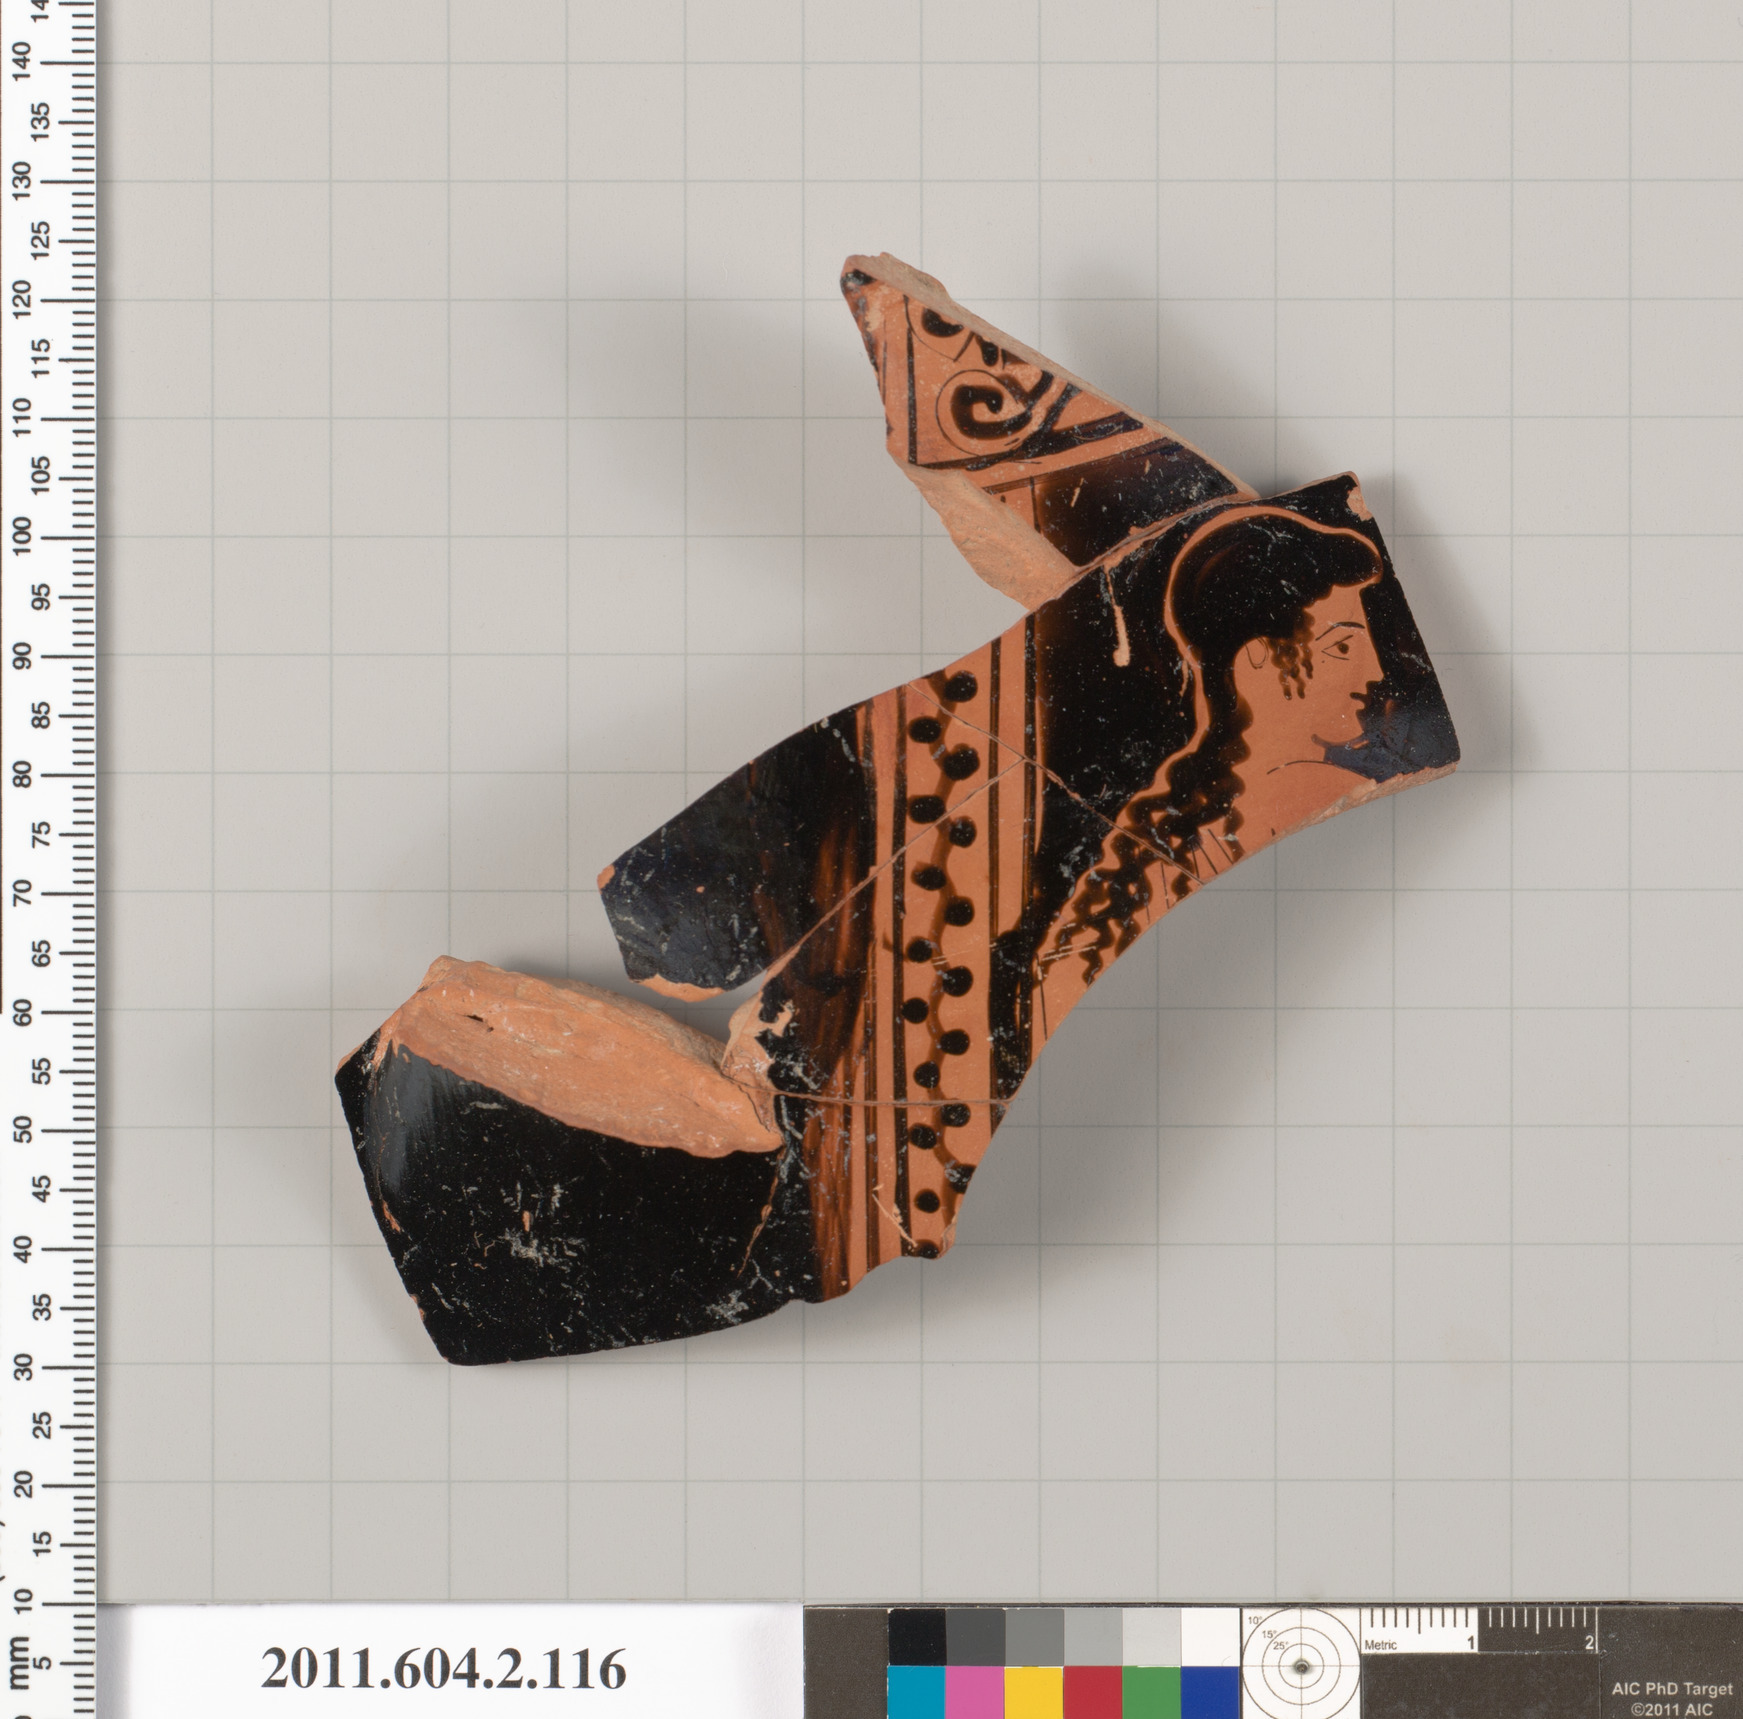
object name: pelike fragment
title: Terracotta fragment of a pelike (jar)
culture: greek, attic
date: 460-450 BCE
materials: terracotta